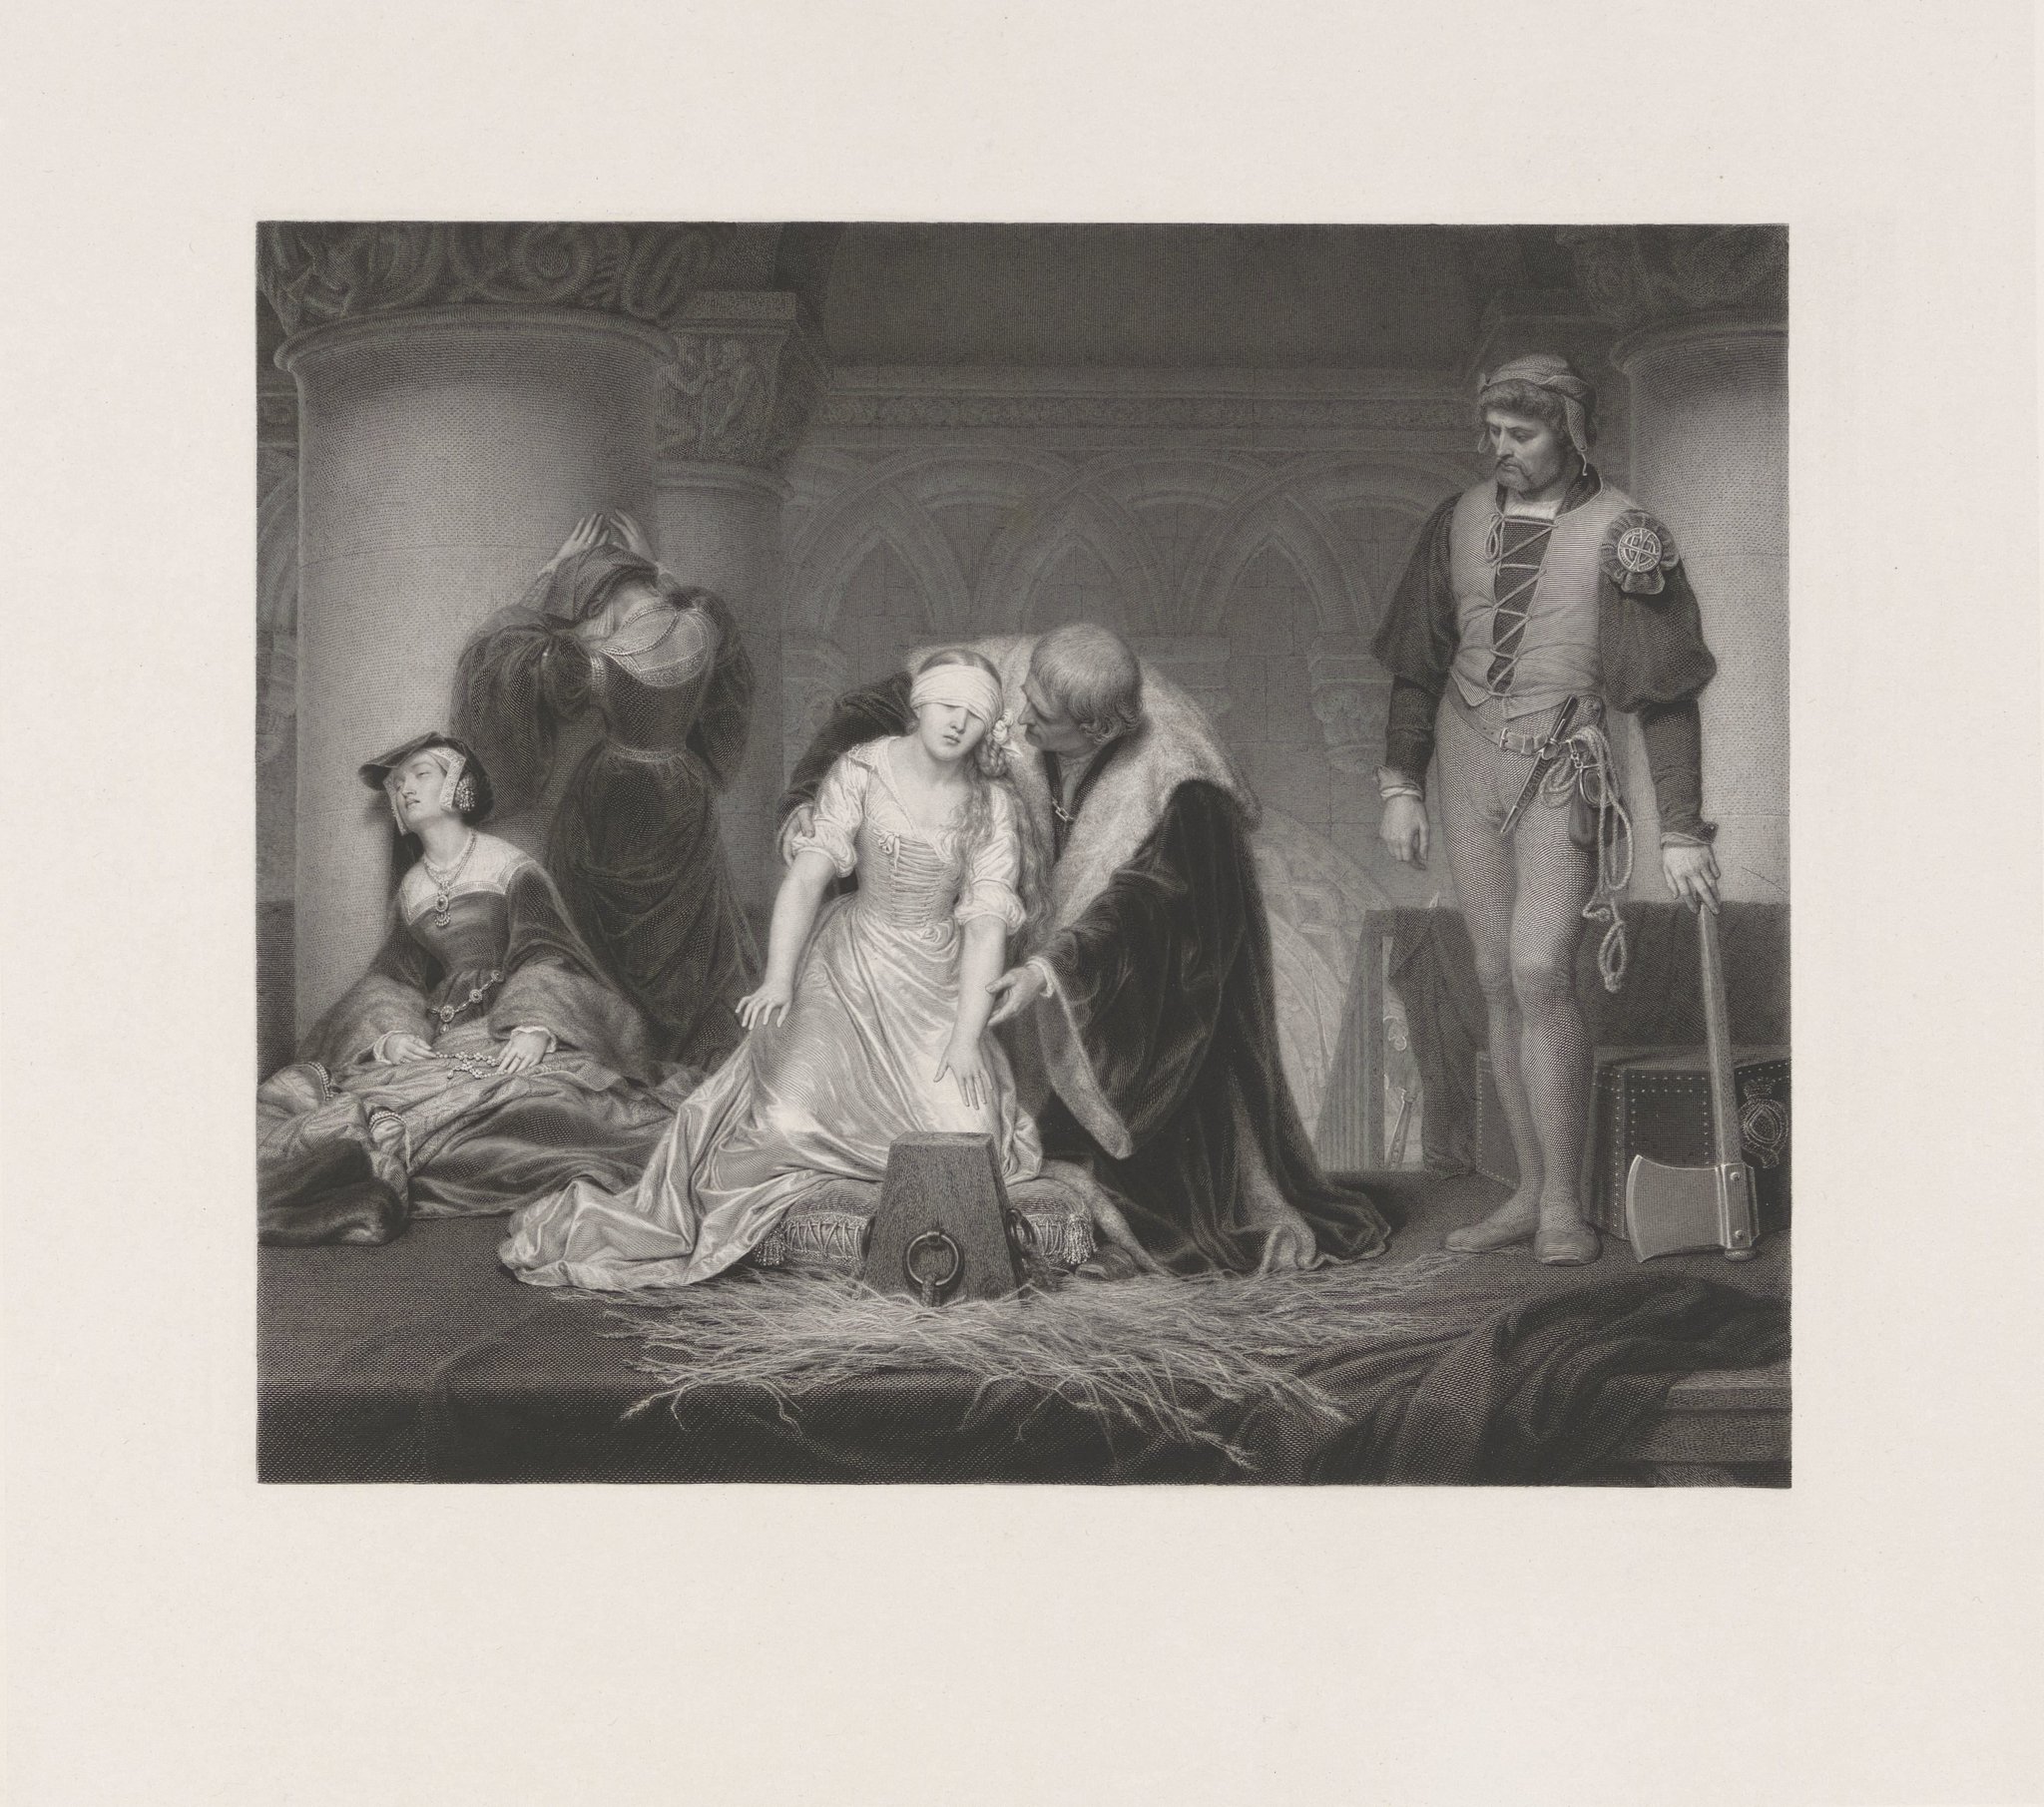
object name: print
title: De terechtstelling van Lady Jane Grey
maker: paolo mercuri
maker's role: print maker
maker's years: 1804-1884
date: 1833-1884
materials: paper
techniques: engraving, etching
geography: italy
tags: london, on the scaffold or place of execution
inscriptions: collector's mark: Lugt 12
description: Lady Jane Grey zit op haar knieën op een kussen. Zij is geblinddoekt en tast met haar handen naar voren. Voor haar staat een hakblok. Een man met een rijke, met bont afgezette mantel buigt zich over haar heen. Ernaast staat de beul met een bijl klaar. Op de achtergrond twee huilende vrouwen.